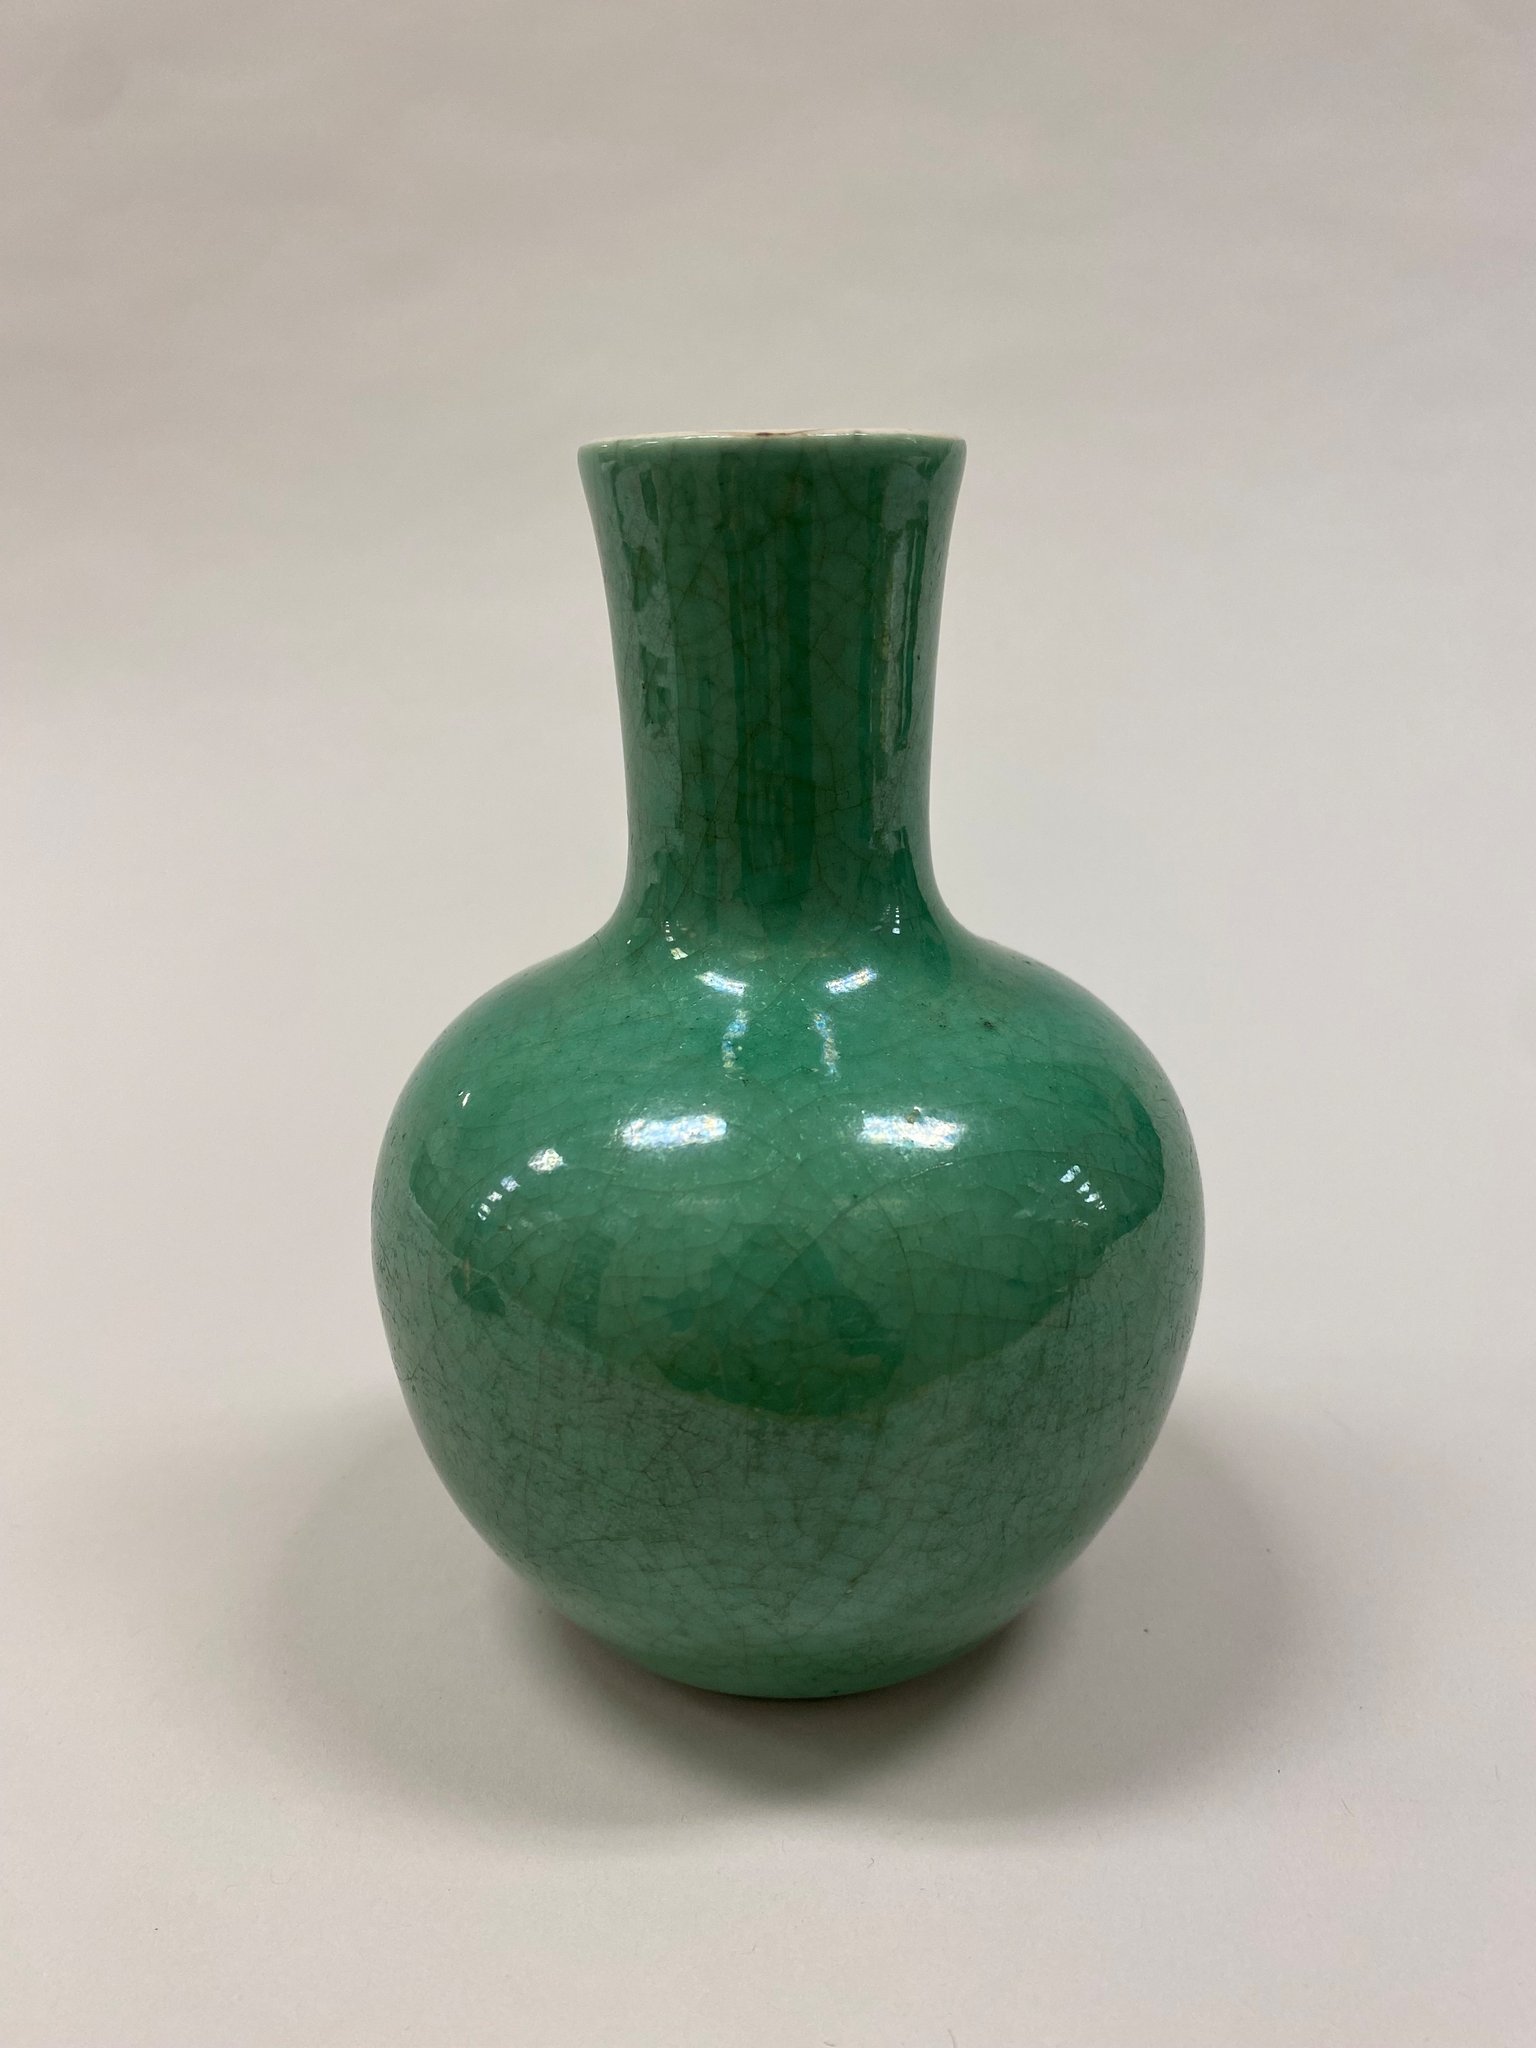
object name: vase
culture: chinese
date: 1701-1800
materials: glaze, porcelain